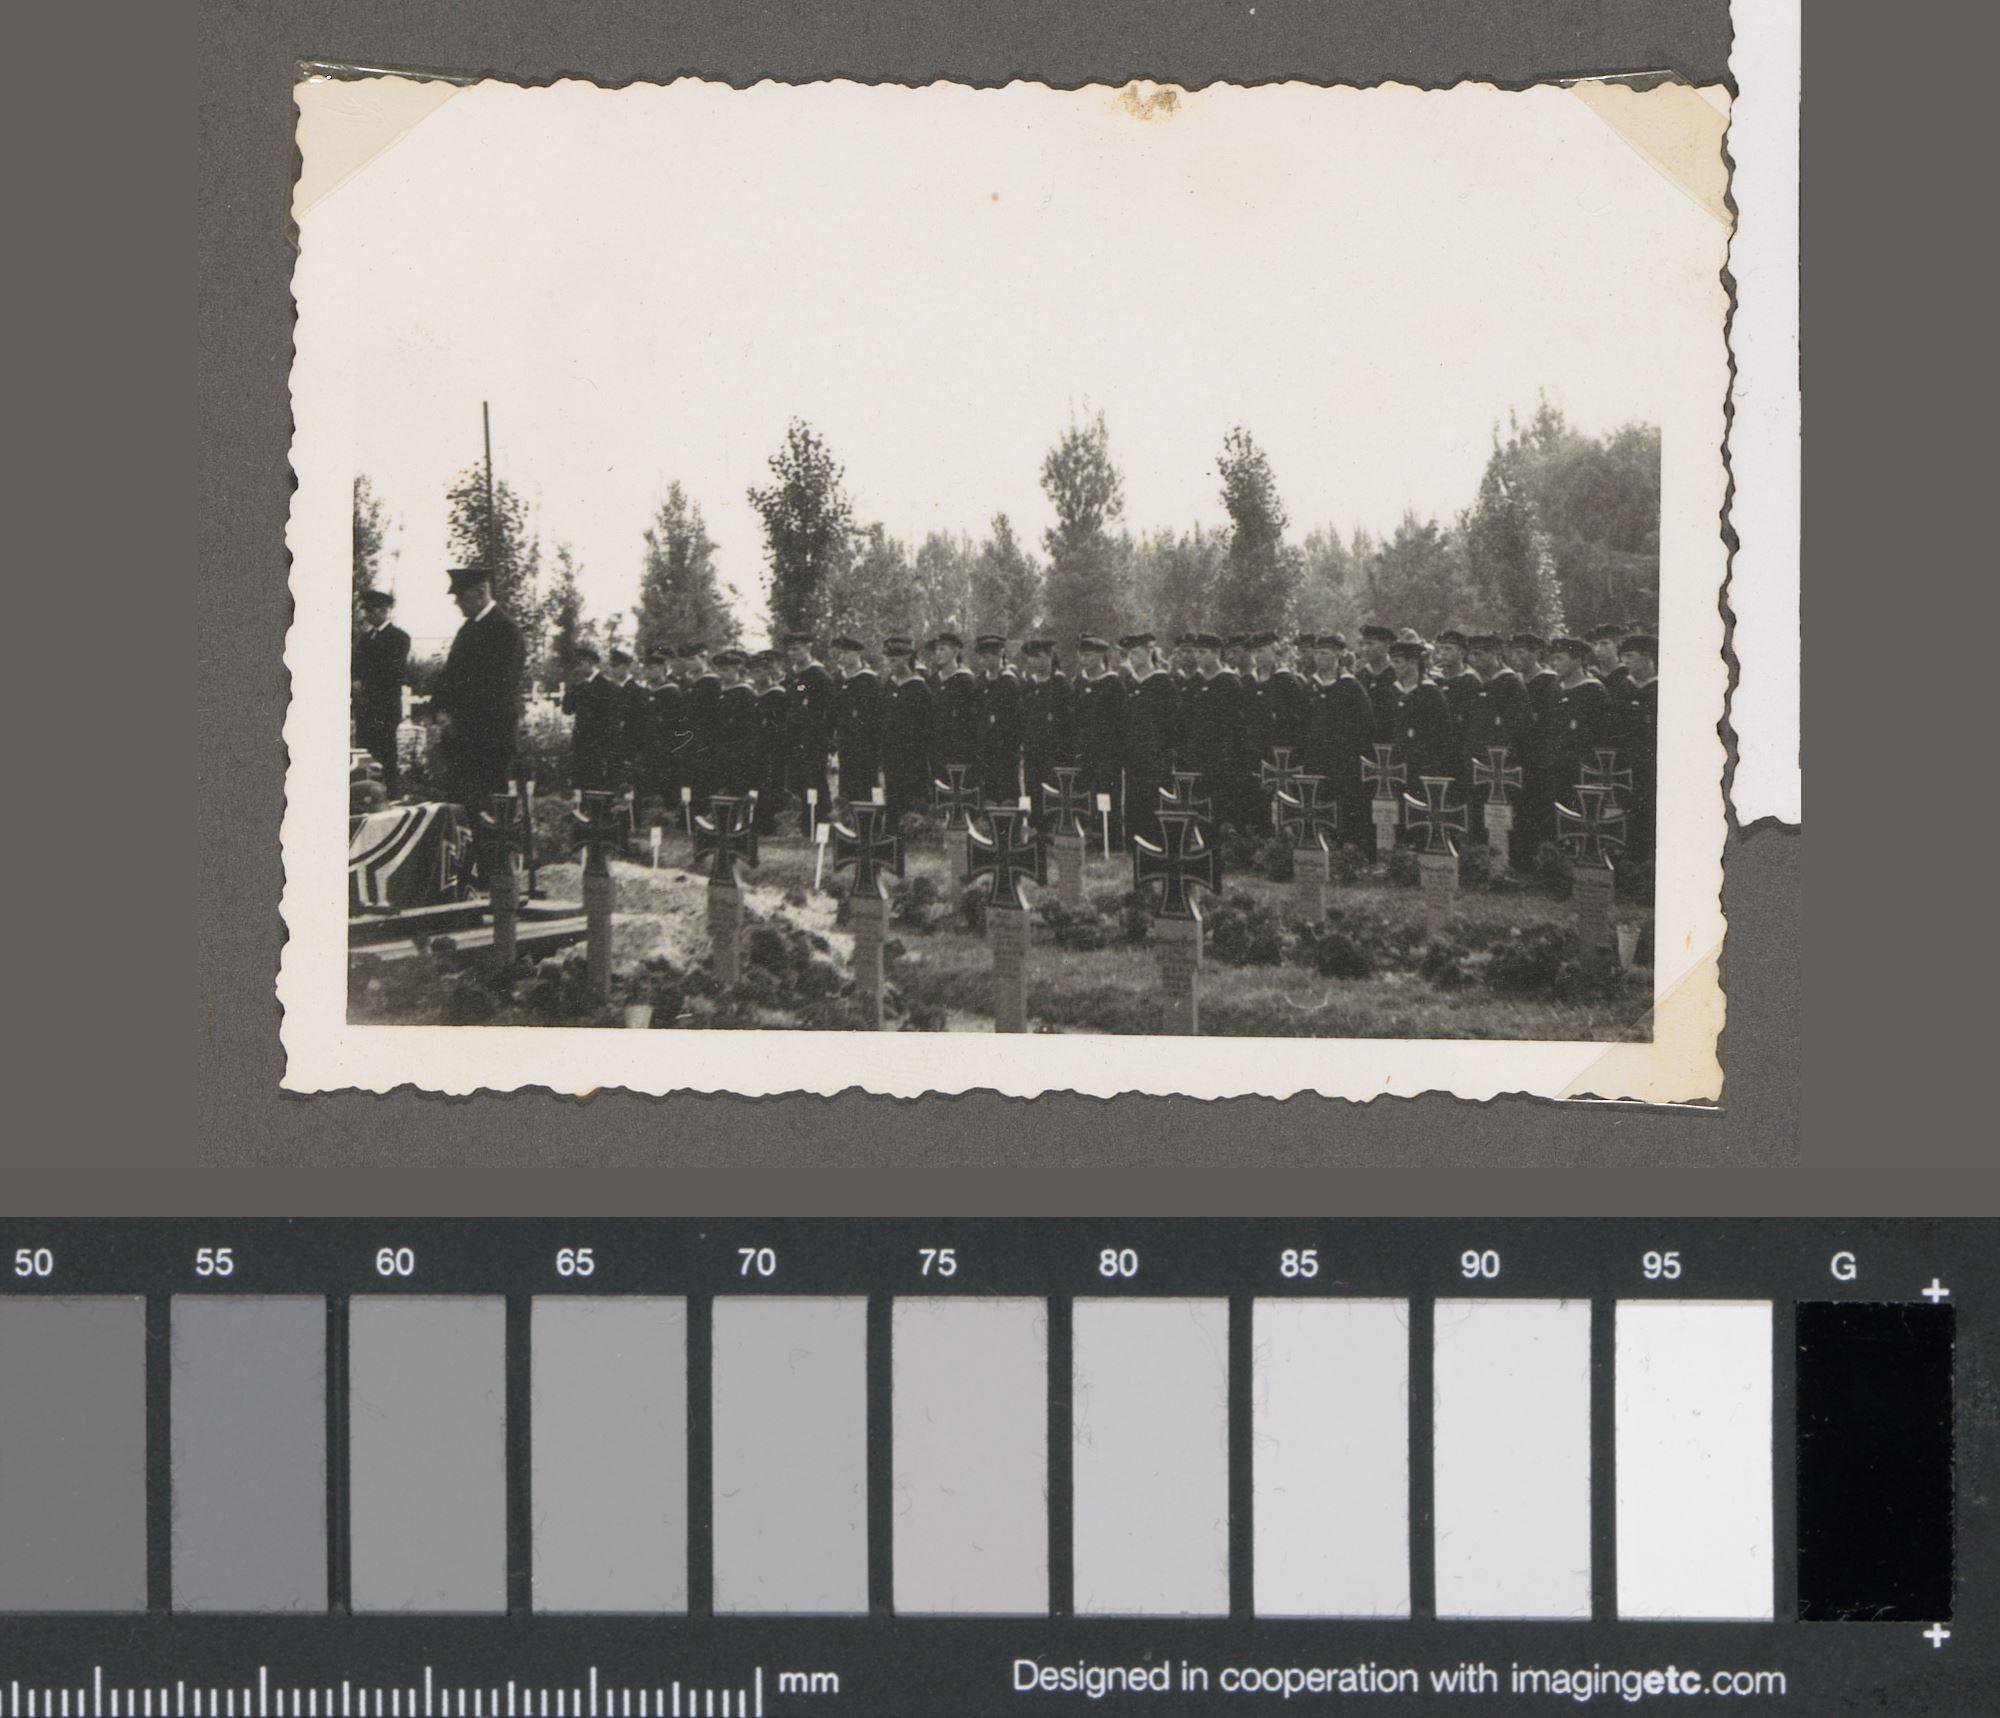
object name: photograph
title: Militairen bij de begrafenis van drie gevallen militairen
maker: Anonymous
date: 1941-1945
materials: paper, photographic support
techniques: gelatin silver print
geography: netherlands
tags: funerary ceremonial, the soldier; the soldier's life, cemetery, park-like burying ground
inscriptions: annotation: ‘Noch: Beisetung der Gefallenen/ von Begleitschiff "Alders"’